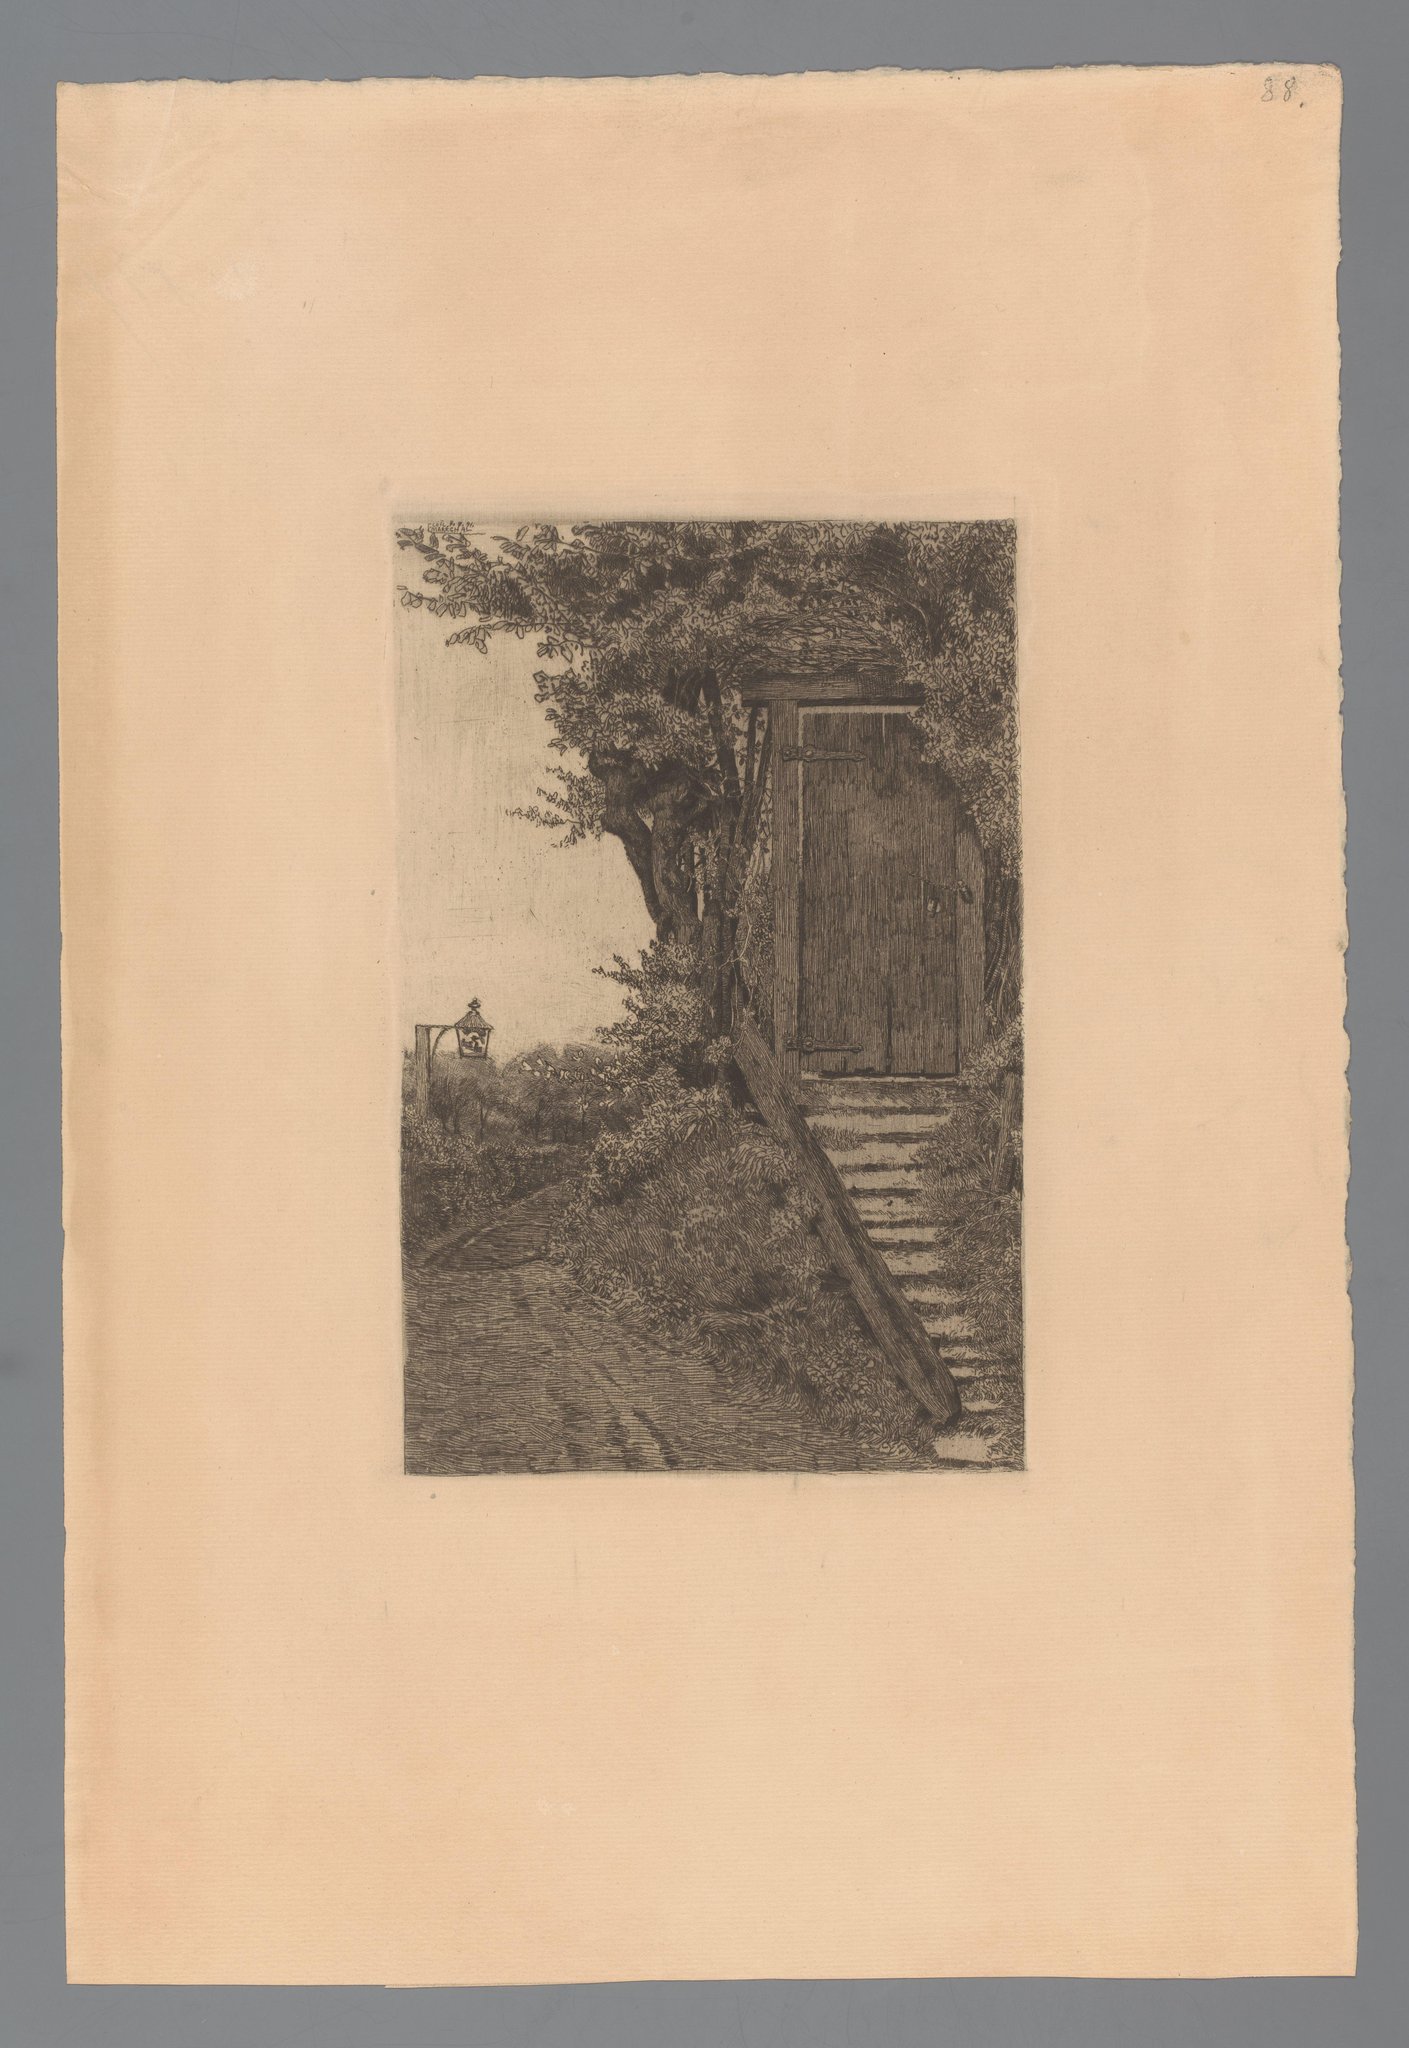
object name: print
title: Deur met trap in de bocht aan een weg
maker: françois maréchal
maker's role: print maker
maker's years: 1861-1945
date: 1891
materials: paper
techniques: etching, intaglio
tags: staircase, street lighting, public road, closed door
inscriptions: collector's mark: Lugt 2228